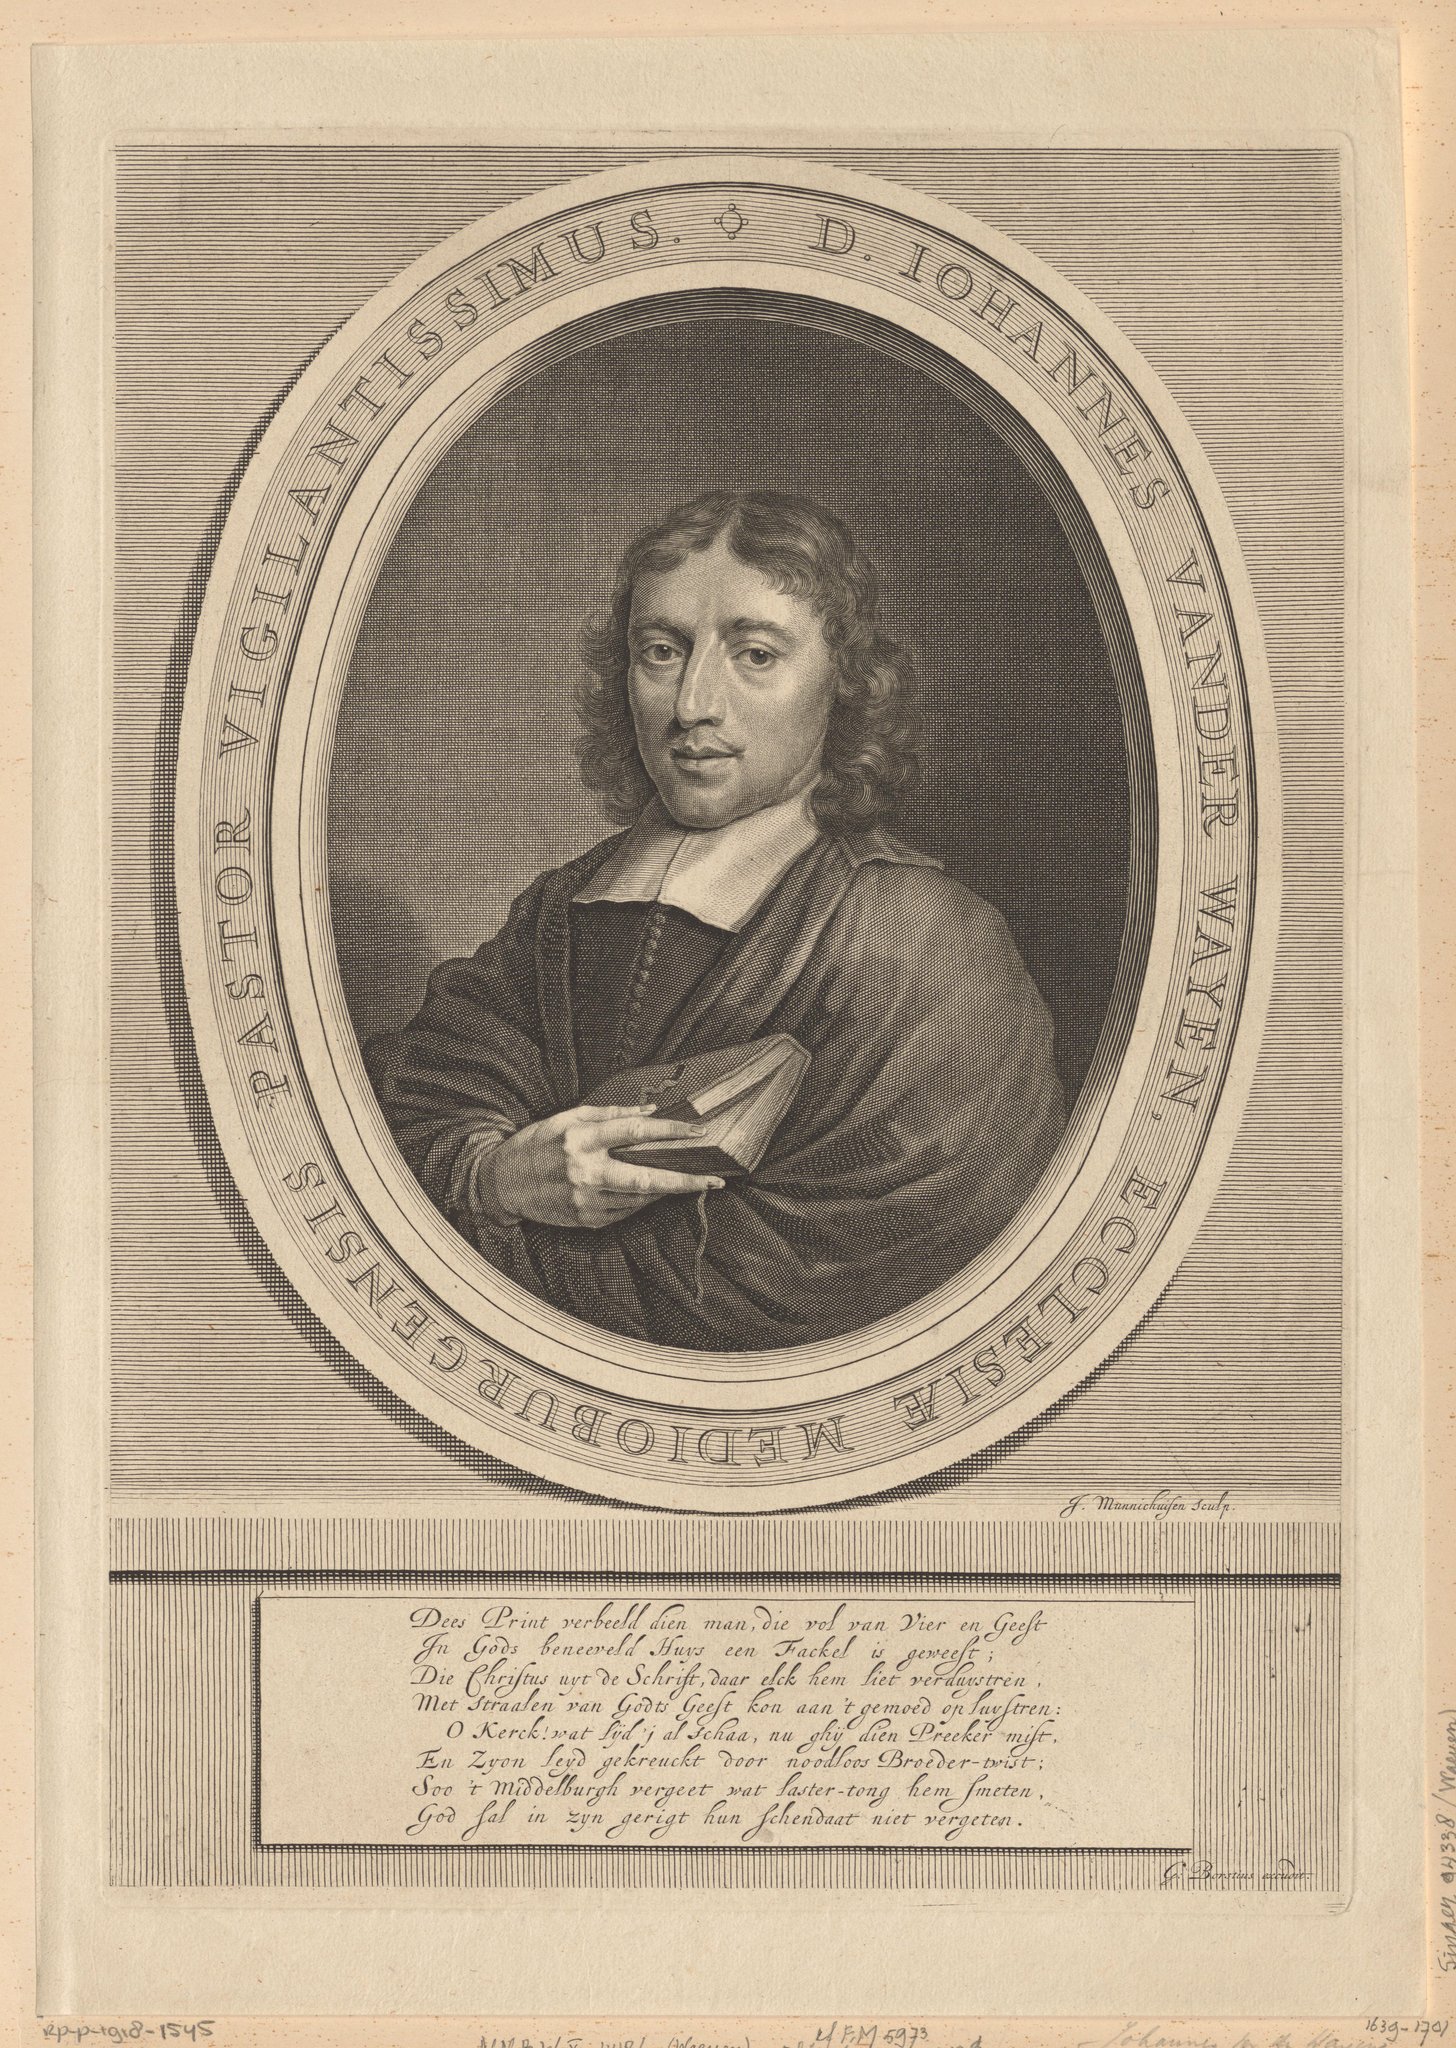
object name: print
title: Portret van Johannes van der Waeyen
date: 1701-1707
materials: paper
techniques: engraving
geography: amsterdam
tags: functionaries and dignitaries (with name) ~ protestant churches, theologian, historical persons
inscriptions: collector's mark: Lugt 2233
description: Onder het portret een achtregelig vers in het Nederlands.